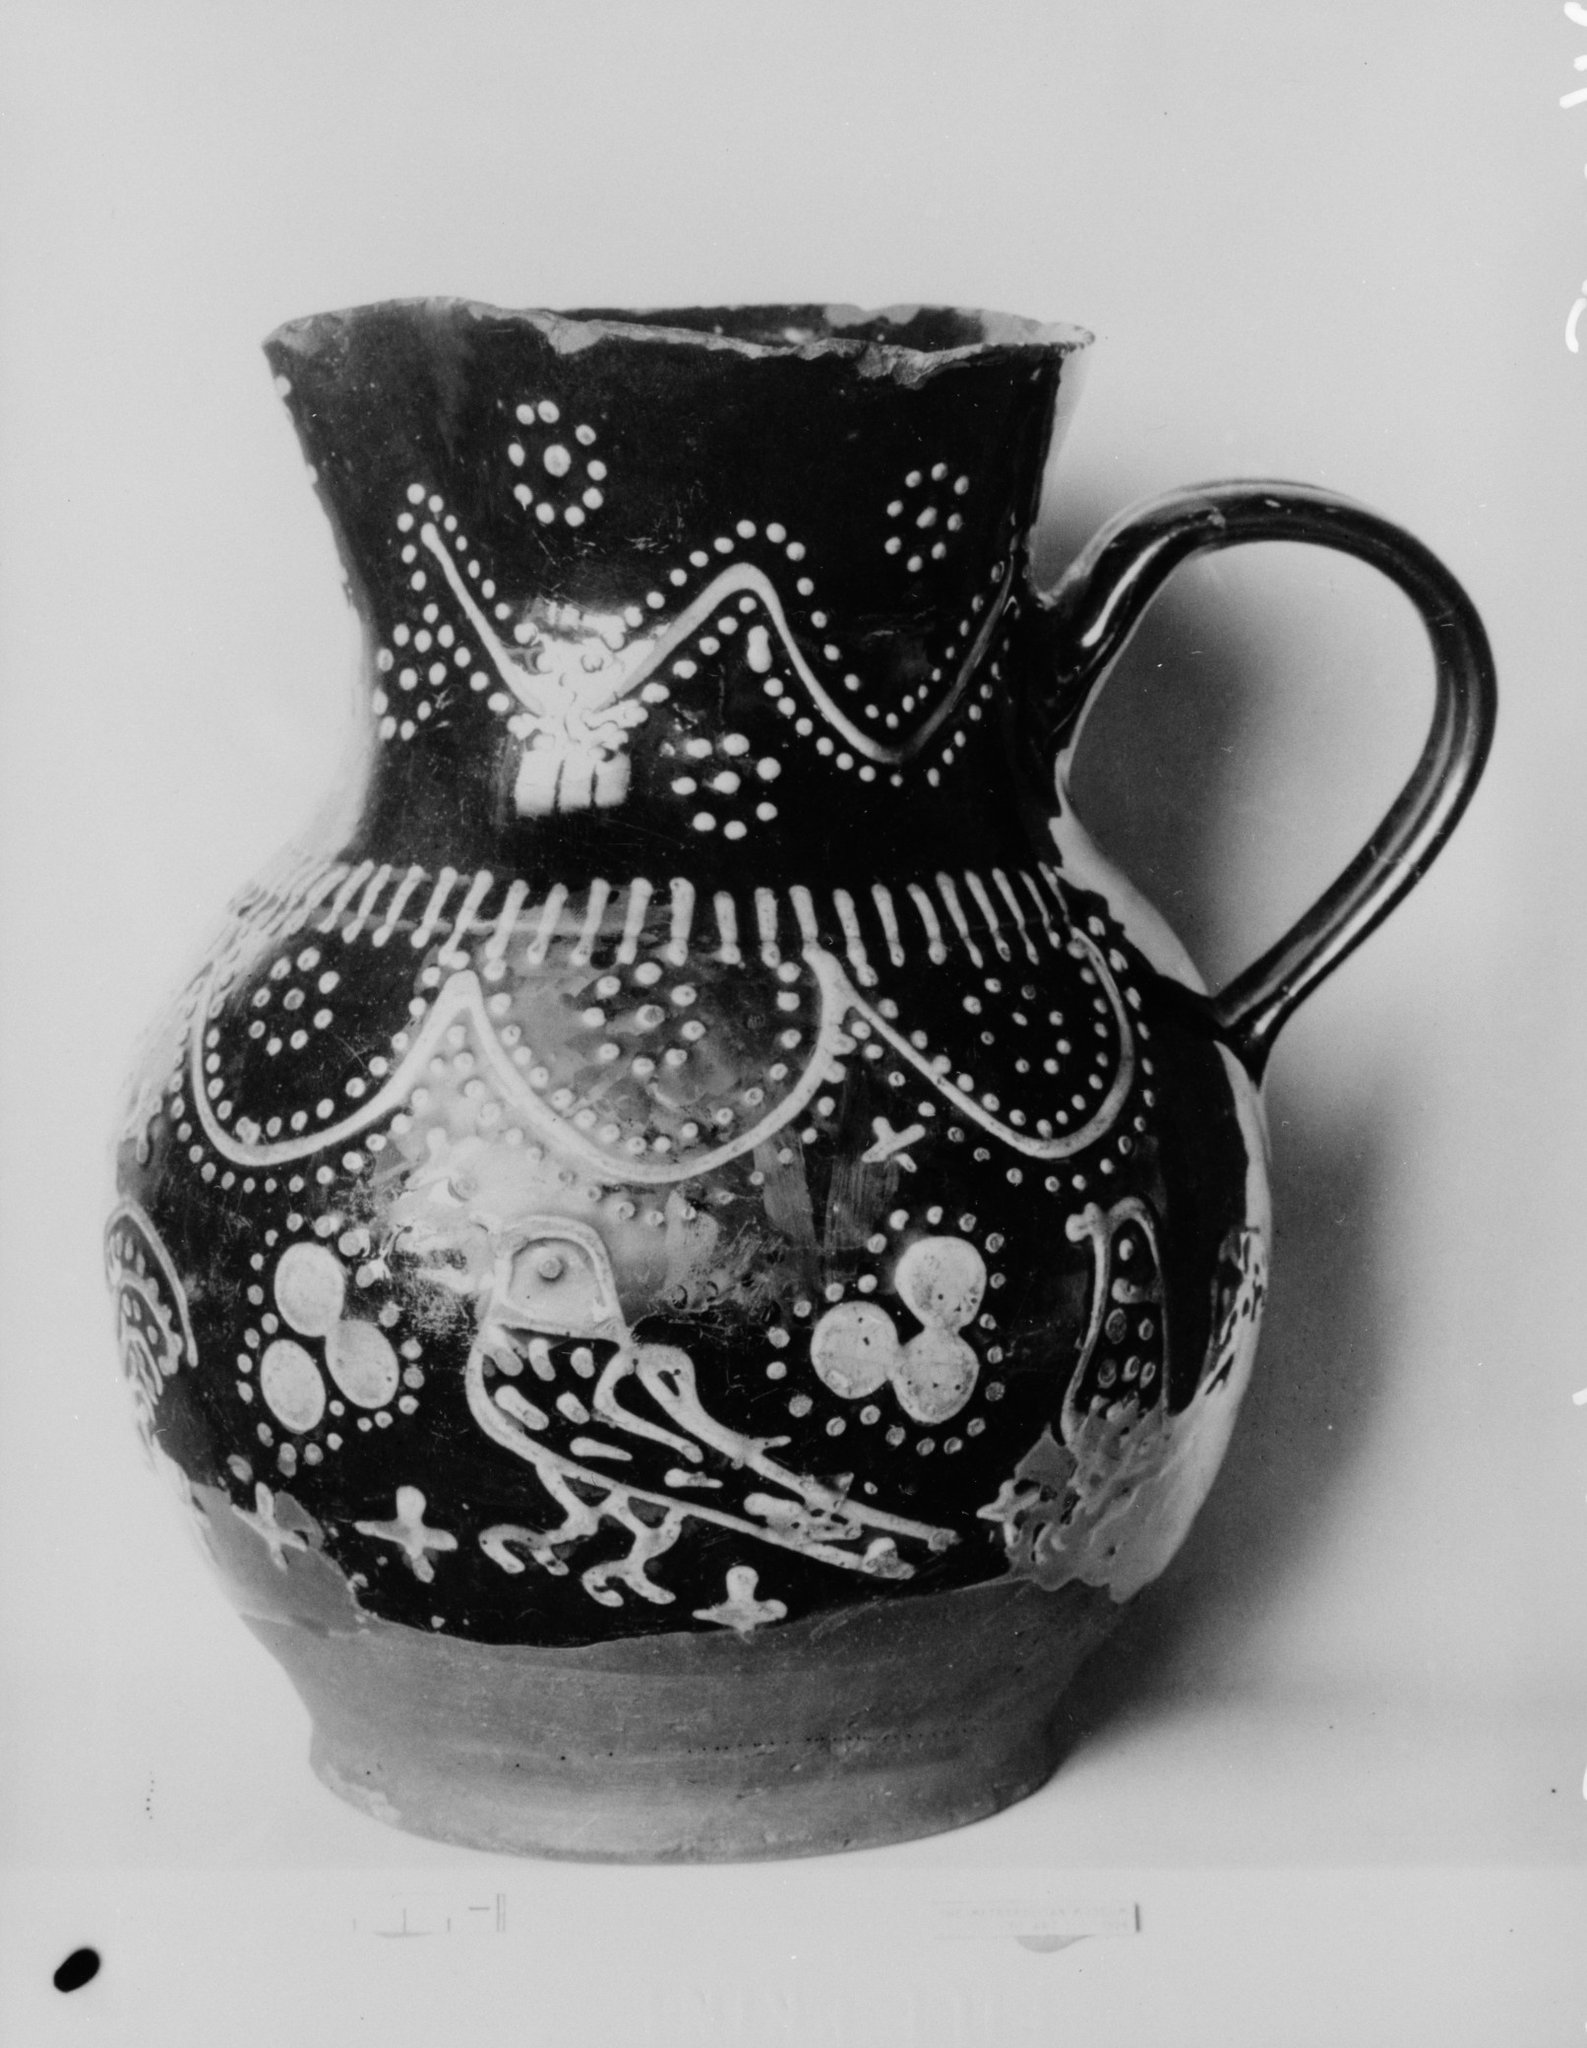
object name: pitcher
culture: british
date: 1700-1710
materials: earthenware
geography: england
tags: birds